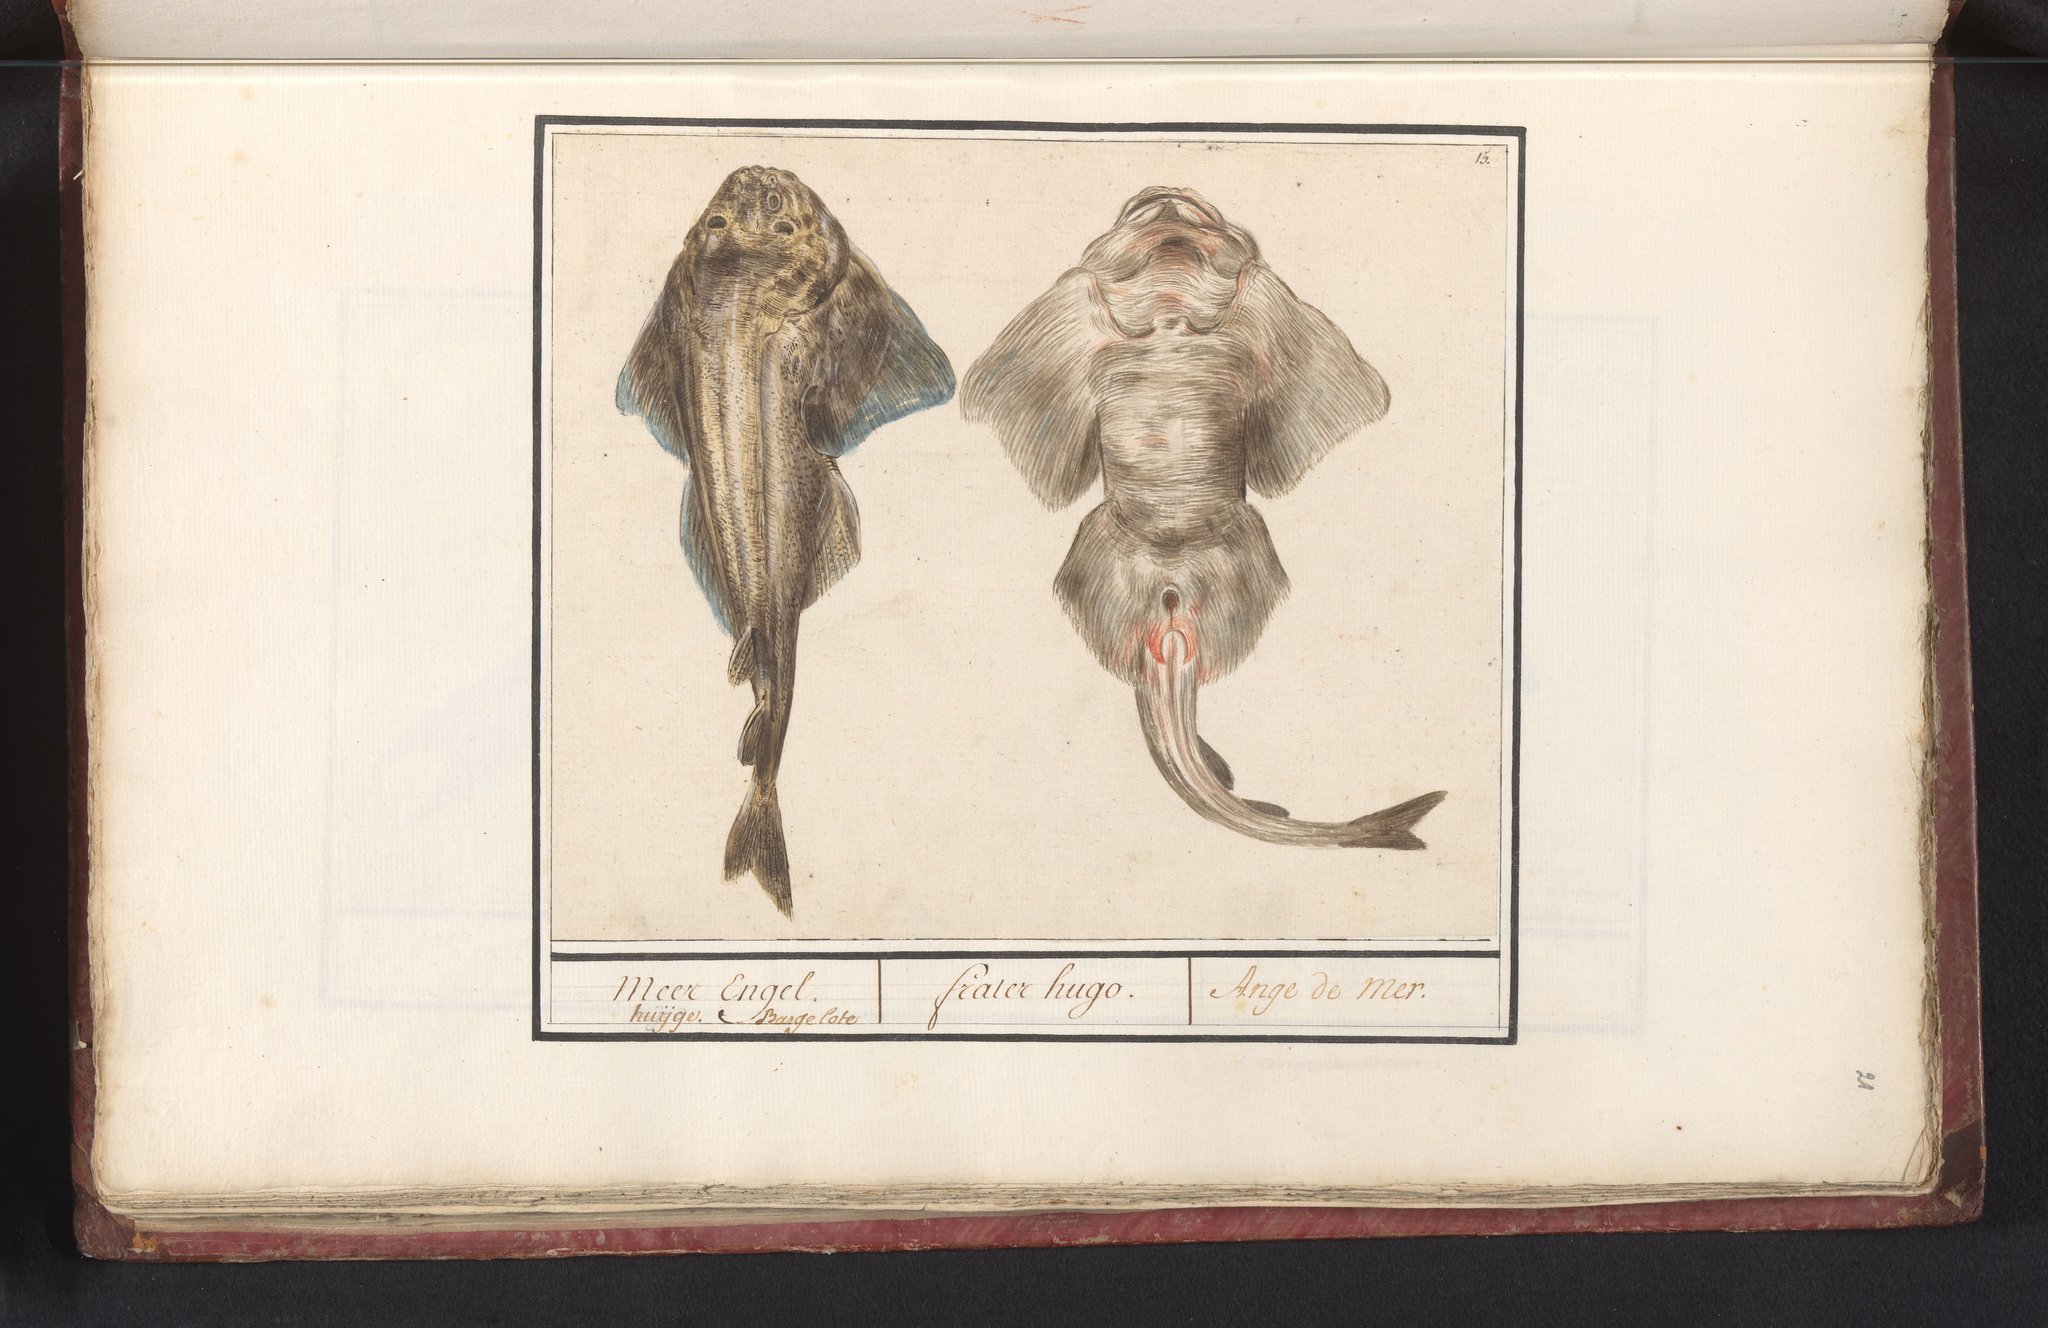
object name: drawing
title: Meer Engel. huijge Bargelote / frater hugo. / Ange de mer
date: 1596-1610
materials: chalk, paint, ink, paper, pencil, watercolor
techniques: brush, pen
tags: cartilaginous fishes: angelshark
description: Squatina (zee-engel) of vioolrog. Genummerd rechtsboven: 15. Onderdeel van het zesde album met tekeningen van vissen, schelpen en insekten. Zesde van twaalf albums met tekeningen van dieren, vogels en planten bekend rond 1600, gemaakt in opdracht van keizer Rudolf II. Met toelichting in Nederlands, Latijn en Frans.